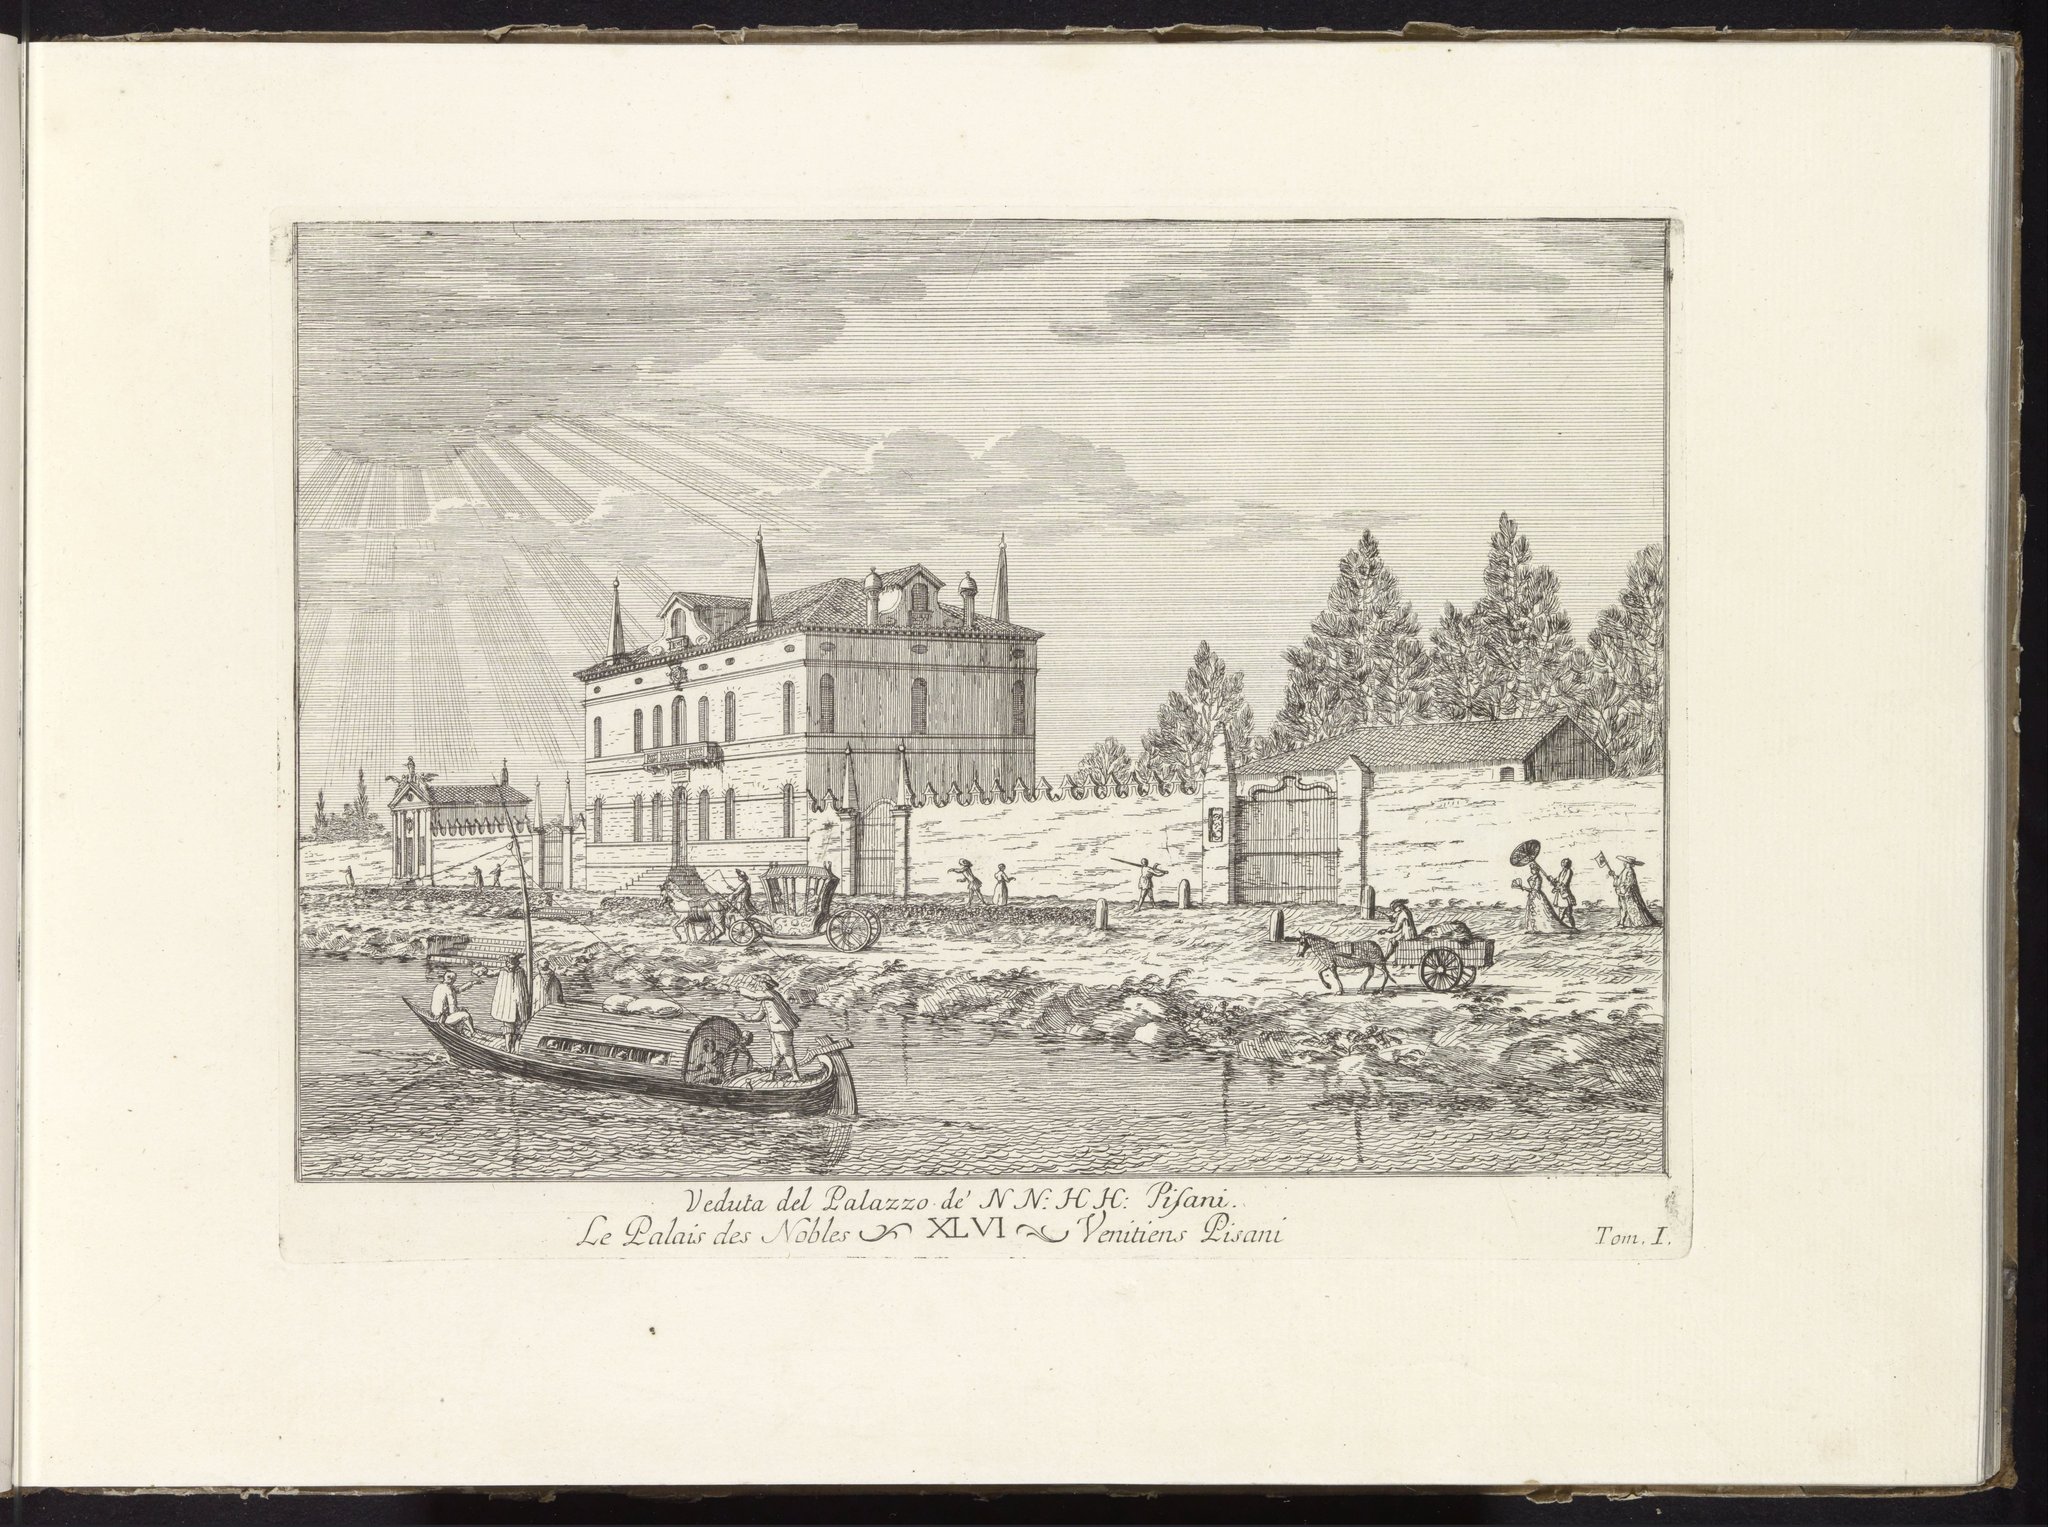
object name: print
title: Les delices de la Brenta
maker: giovanni francesco costa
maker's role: draughtsman, painter, print maker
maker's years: -1773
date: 1750-1760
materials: paper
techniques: etching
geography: italy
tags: river, tow-boat, towing-barge, hôtel, i.e. small palace in city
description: Gezicht op Palazzo de' N N: H H: Pisani aan de rivier de Brenta. Op het water vaart een trekschuit. Aan de waterkant wandelen mensen en rijden mensen in een rijtuig. Genummerd midden onder: XLVI en rechtsonder: Tom: I. Deze prent maakt deel uit van een album.